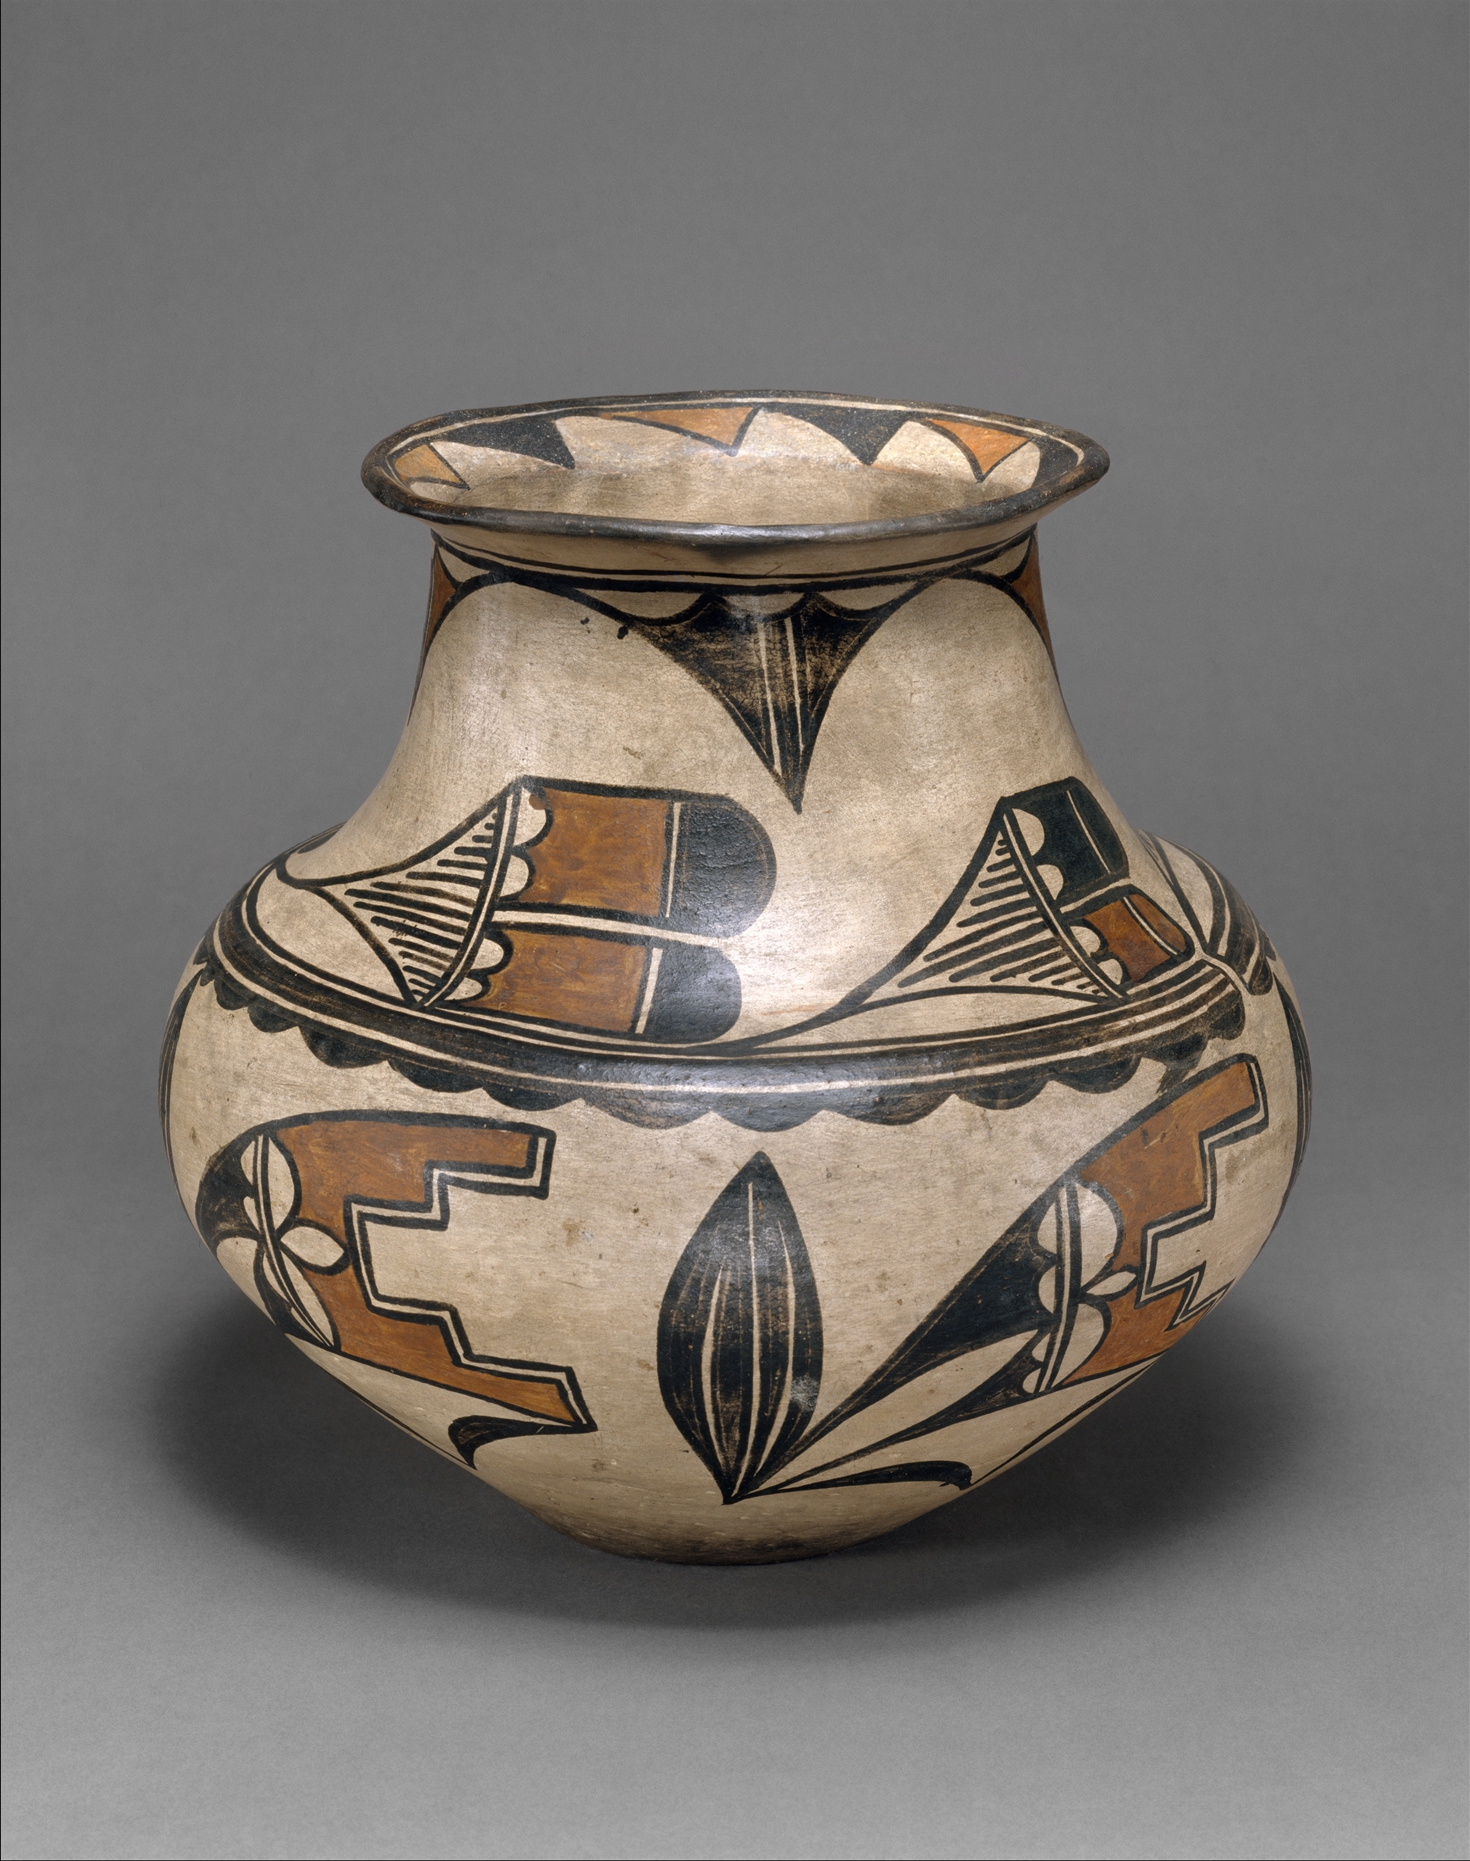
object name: jar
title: Storage Jar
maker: martina vigil montoya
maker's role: artist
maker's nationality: american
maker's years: 1856-1916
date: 1904-1905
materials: ceramic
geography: united states